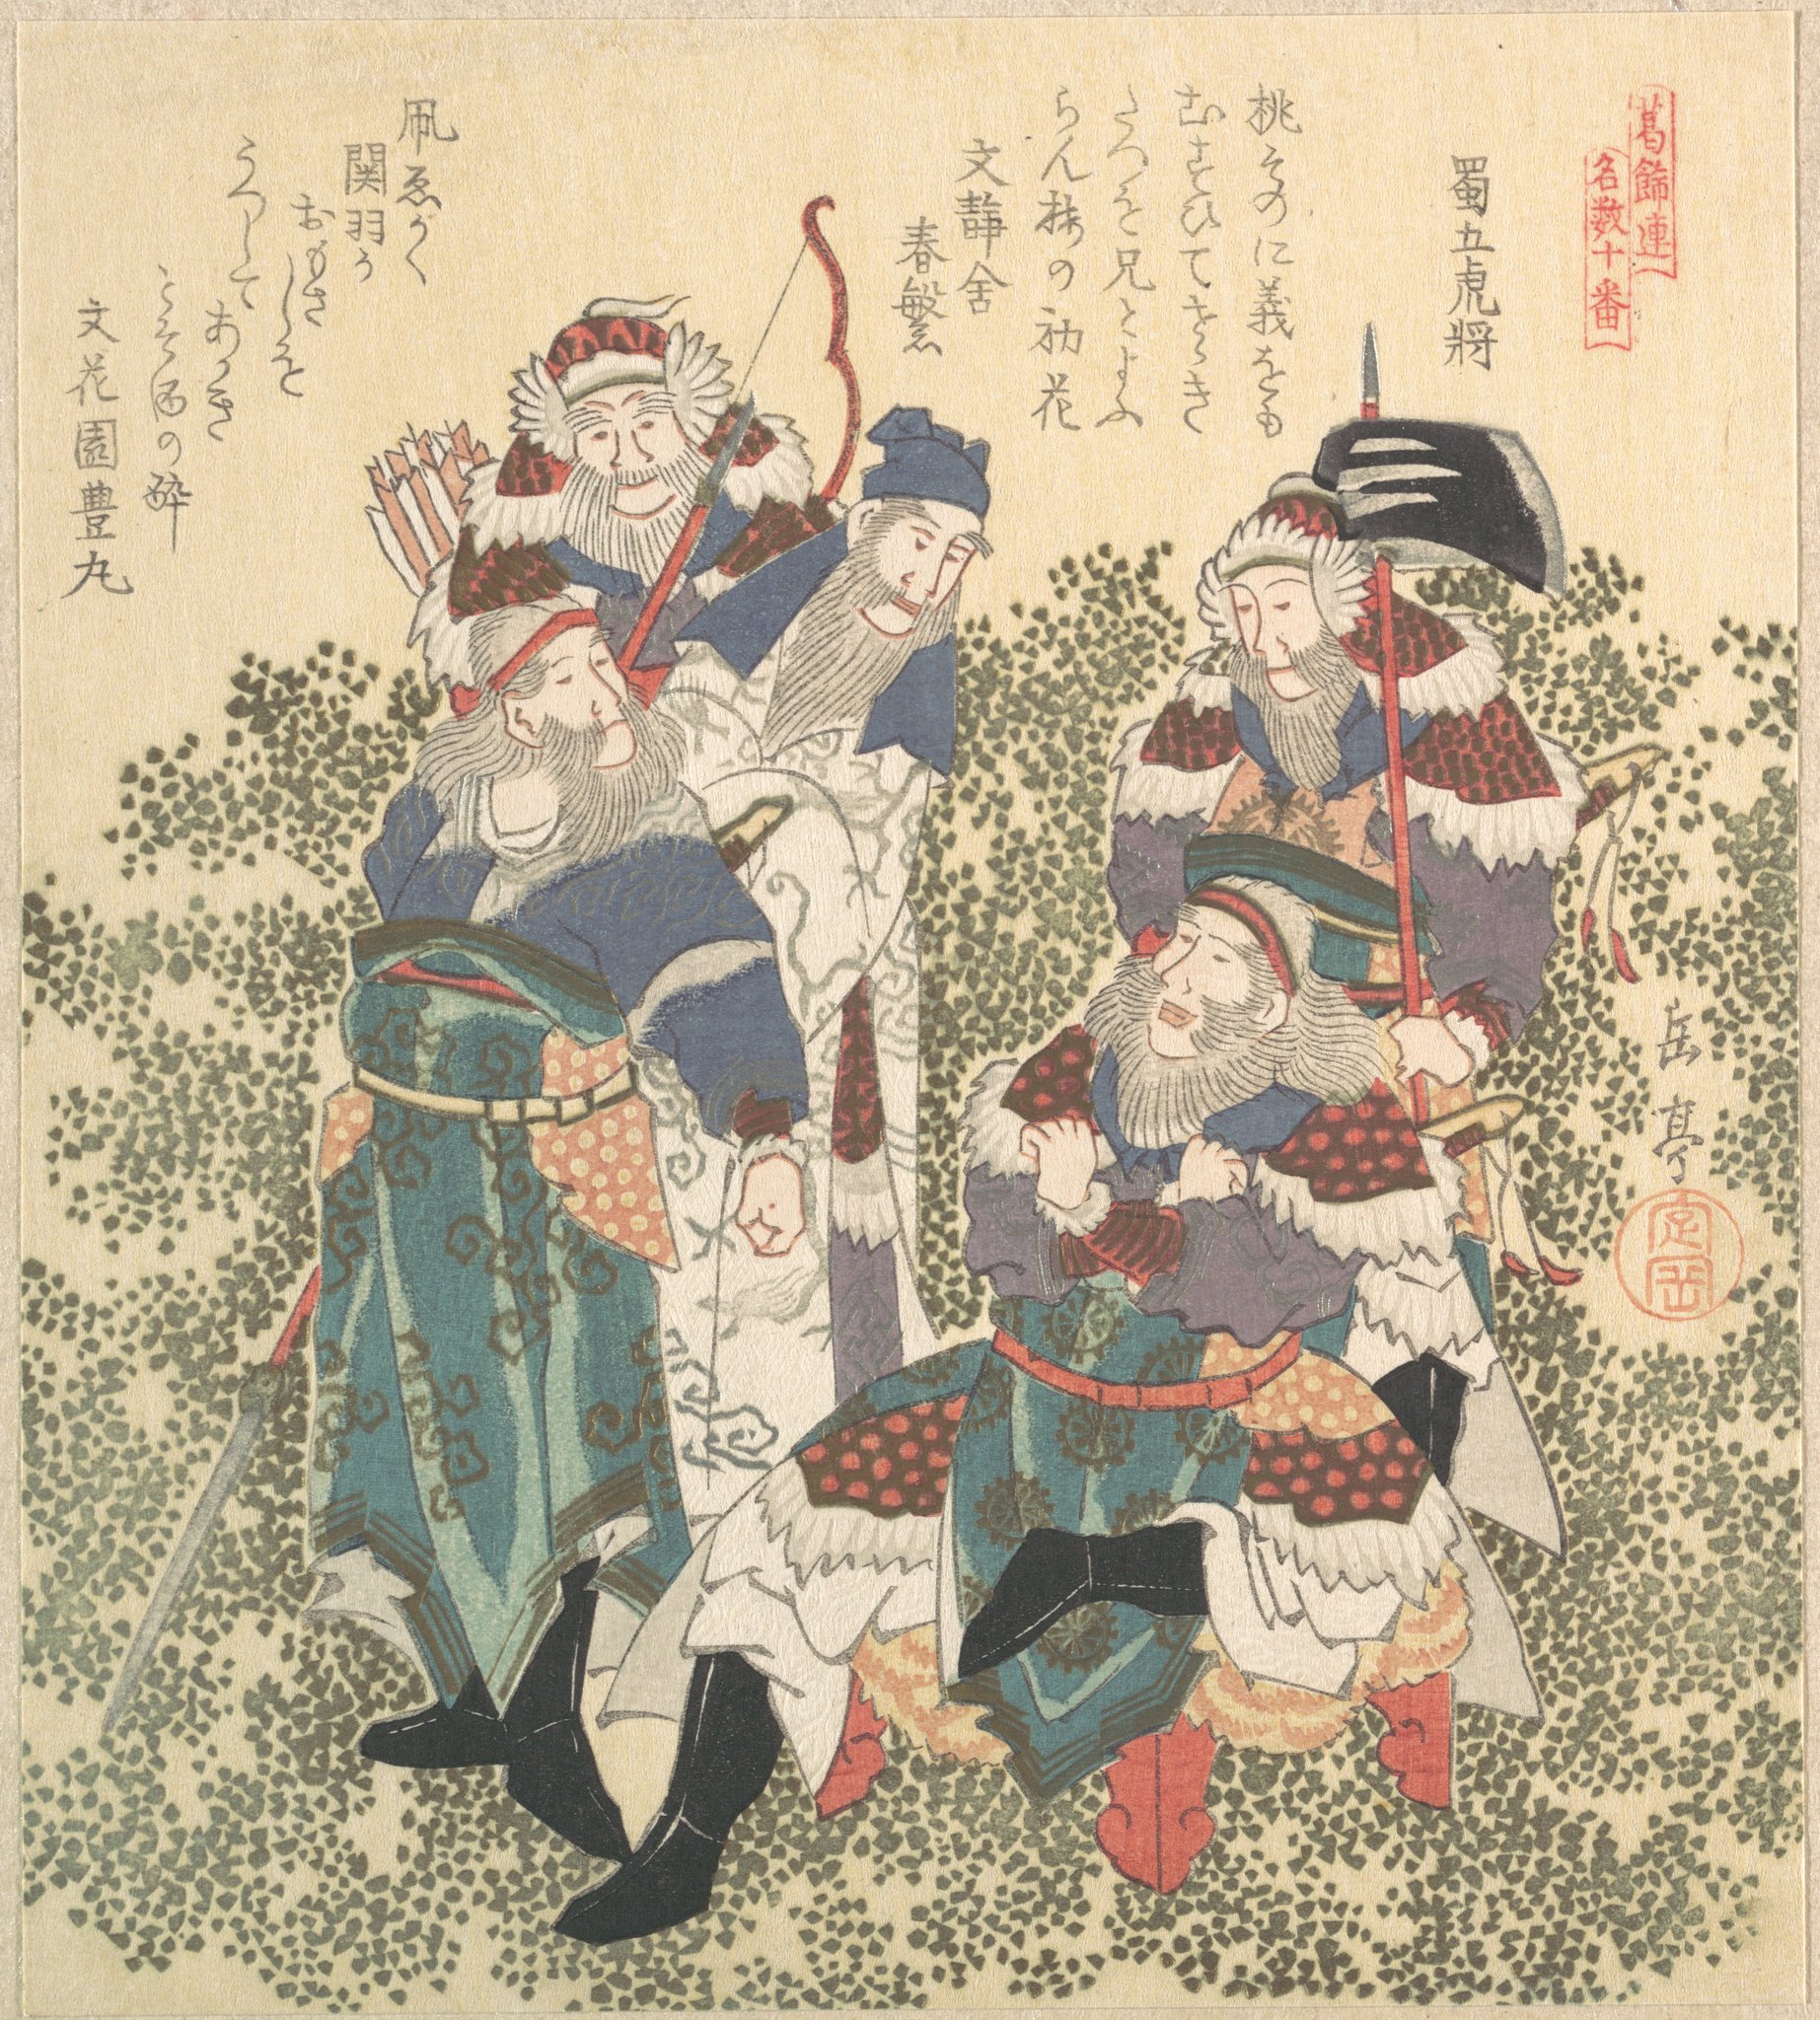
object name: print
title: Five Great Soldiers of Shoku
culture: japanese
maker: yashima gakutei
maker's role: artist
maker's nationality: japanese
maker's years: 1786-1868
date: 1801-1900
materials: ink, paper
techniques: surimono, woodblock print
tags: arrows,swords